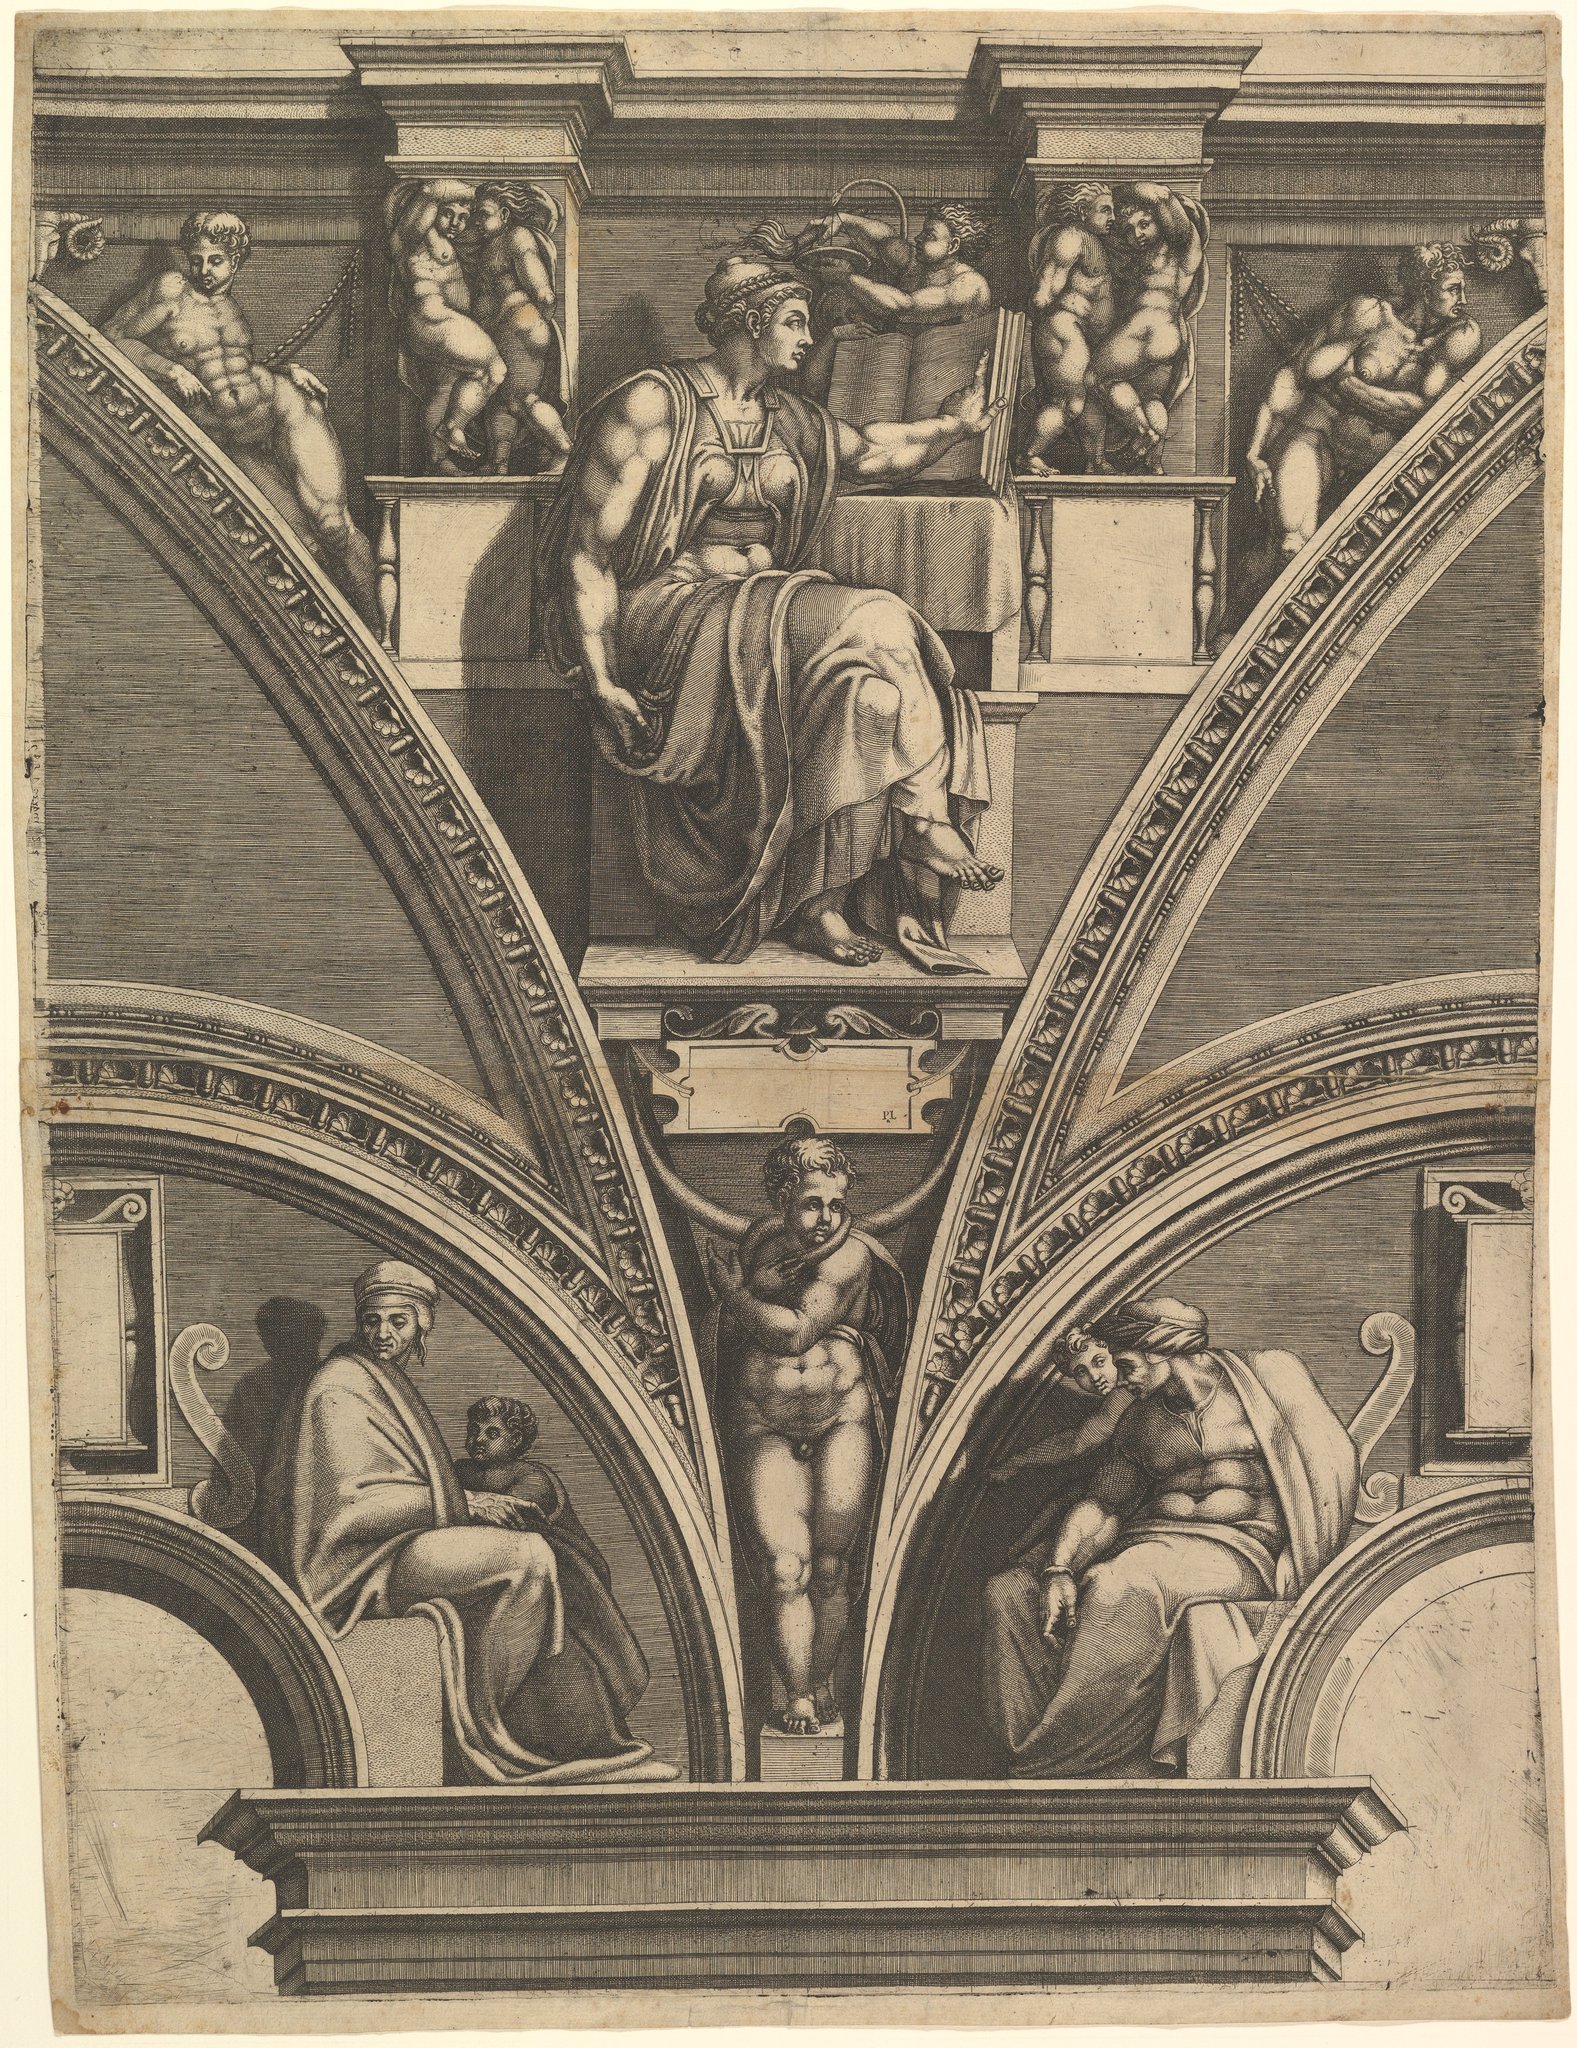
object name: print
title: The Eritrean Sibyl; from "Prophets and Sibyls in the Sistine Chapel"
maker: giorgio ghisi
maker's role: artist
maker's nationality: italian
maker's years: 1515-1582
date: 1570-1575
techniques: engraving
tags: men